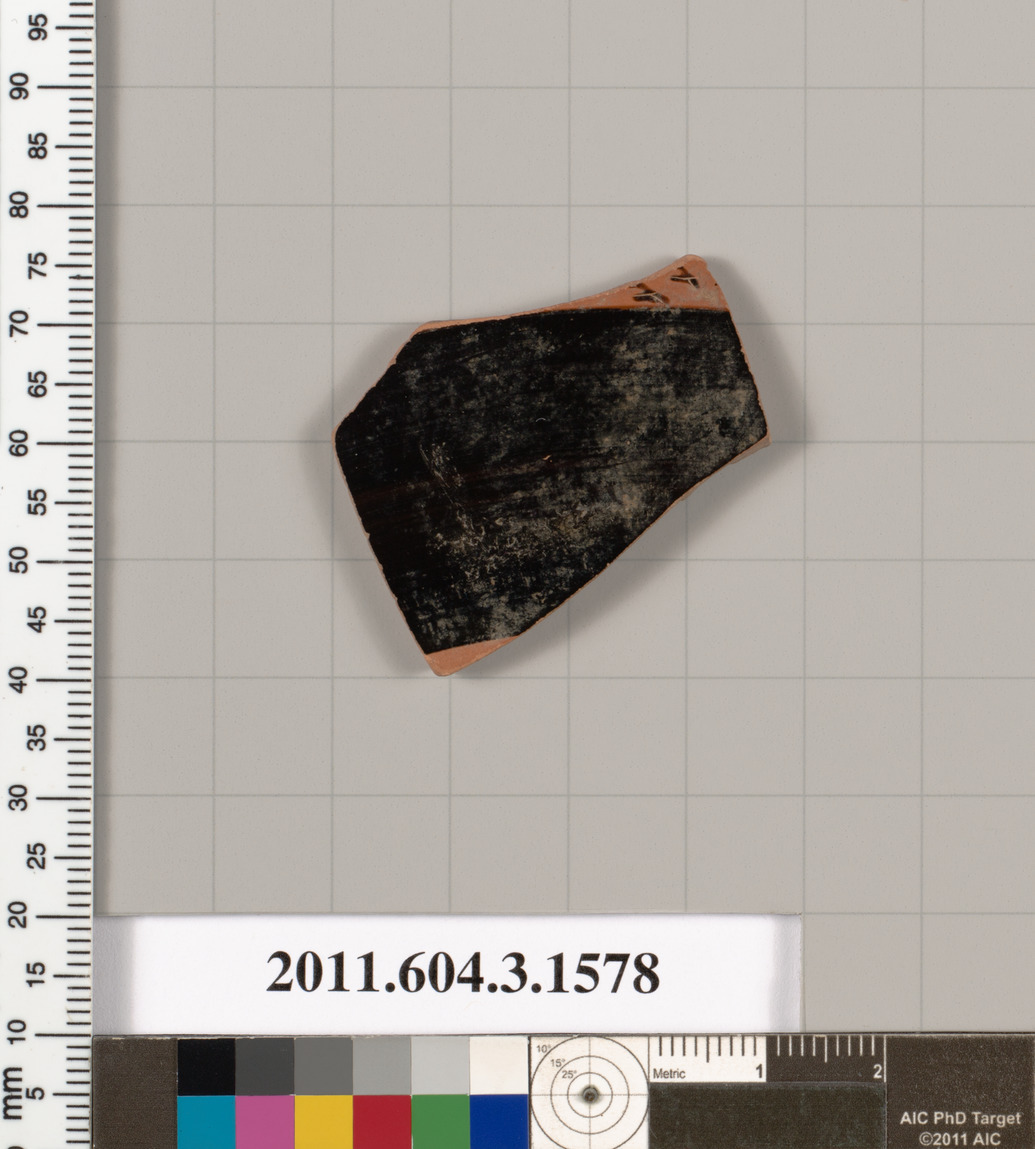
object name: kylix fragment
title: Terracotta fragment of a kylix: Band cup (drinking cup)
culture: greek, attic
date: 550-526 BCE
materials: terracotta